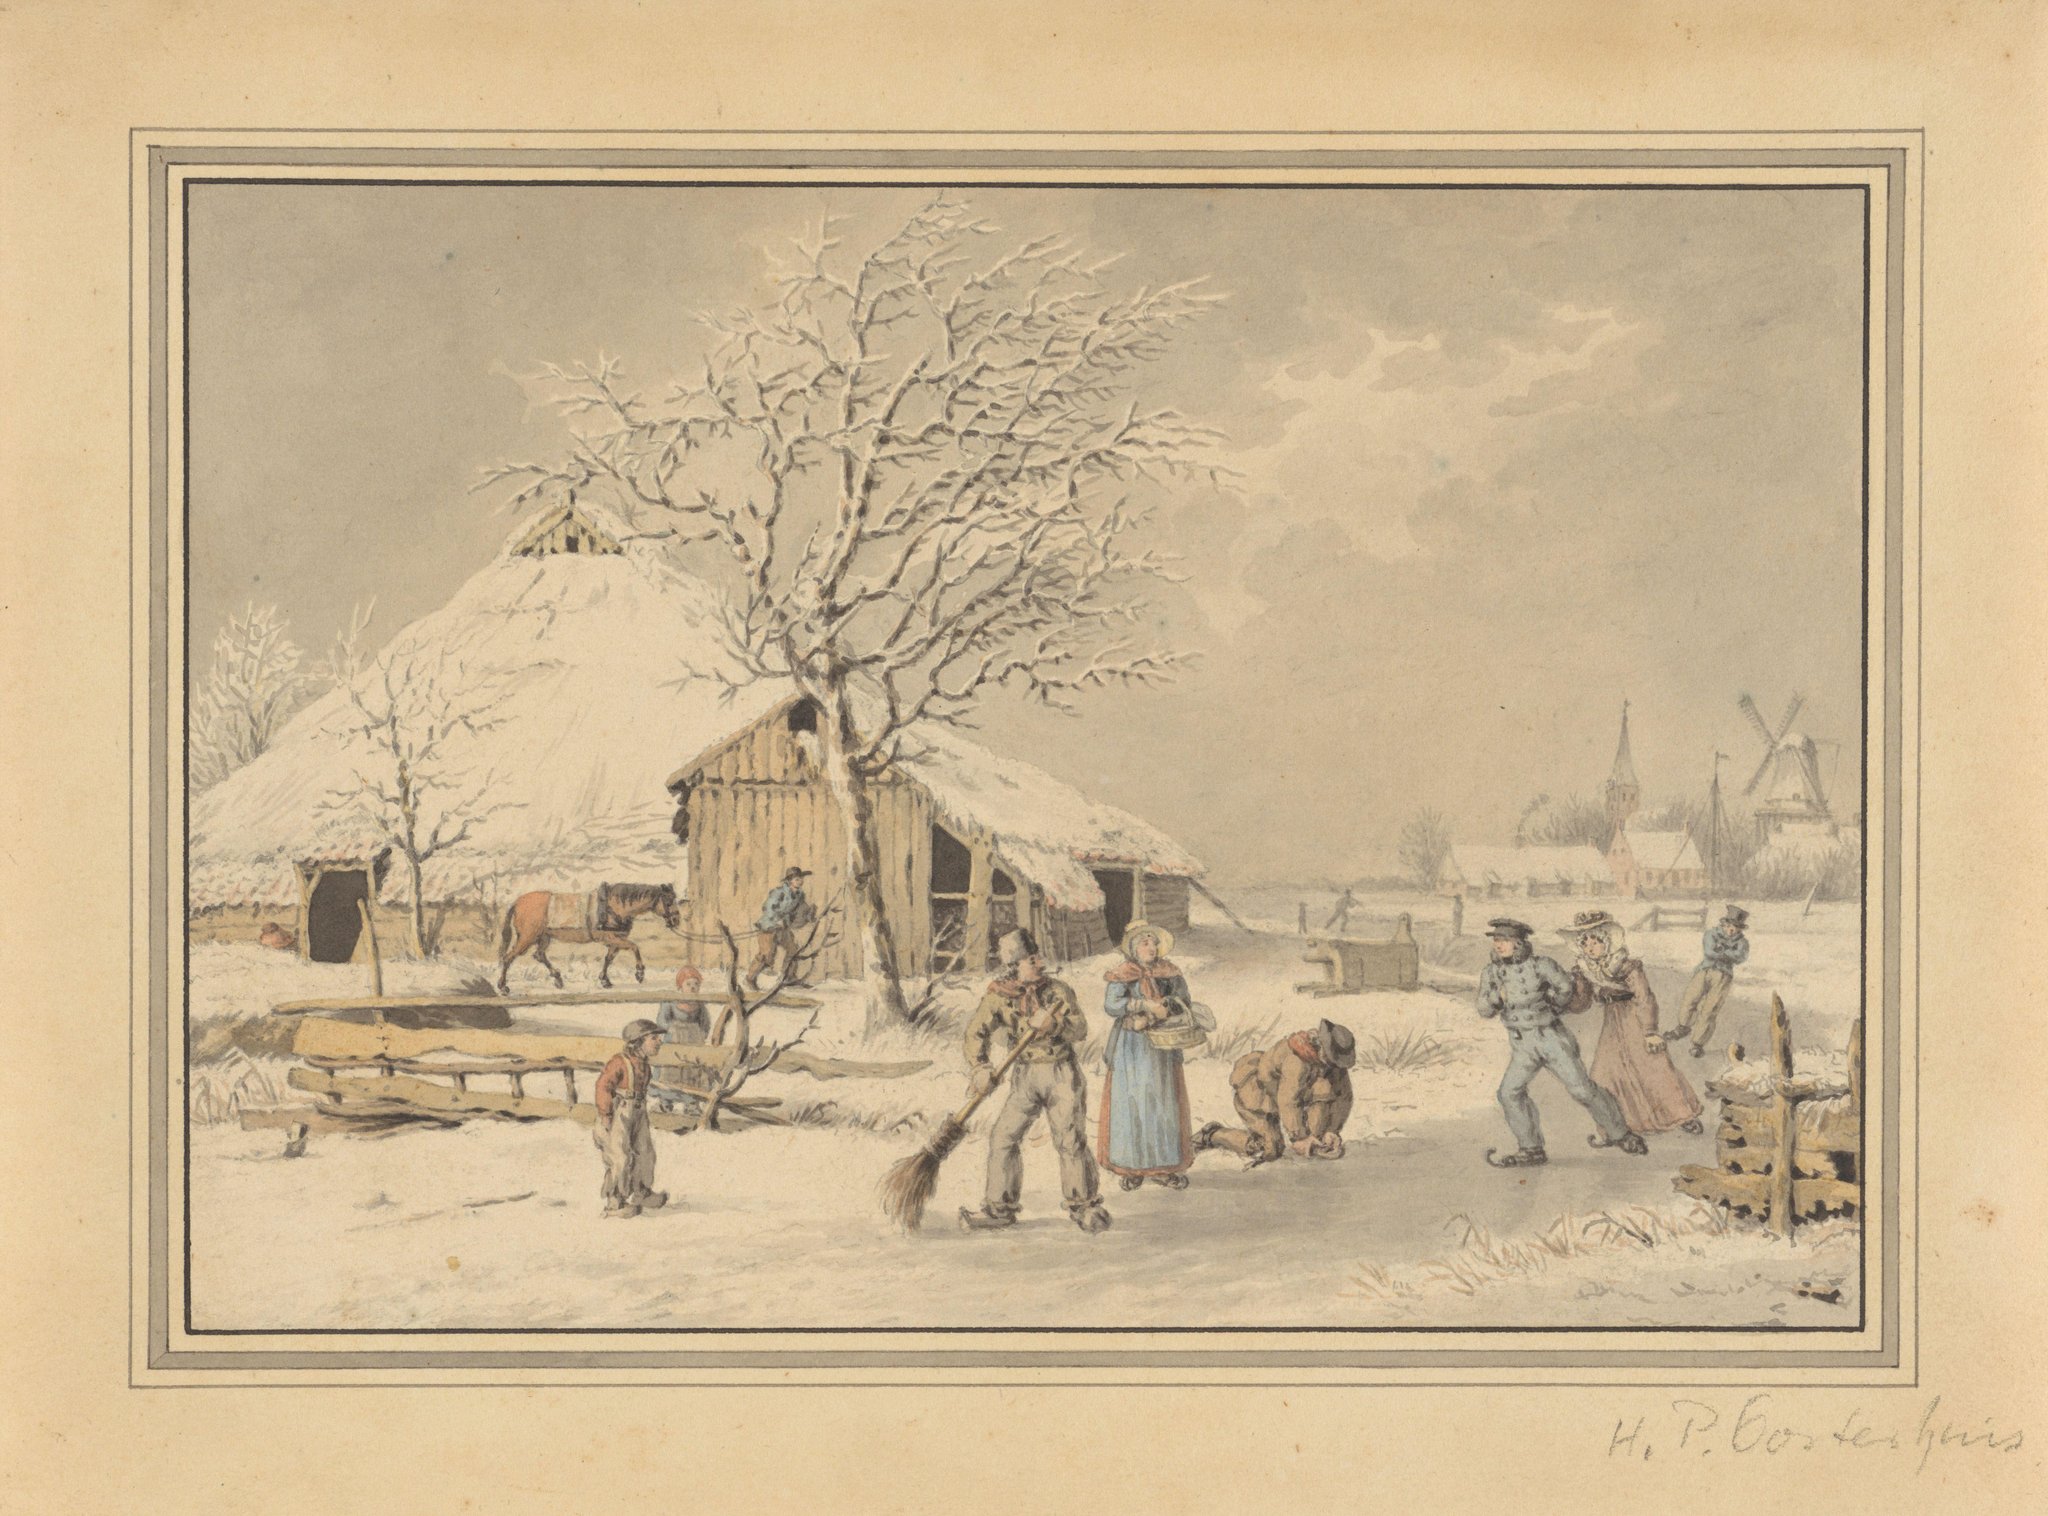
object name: watercolor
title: Winterlandschap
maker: haatje pieters oosterhuis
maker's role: draughtsman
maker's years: 1784-1854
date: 1794-1854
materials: paper, watercolor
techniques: brush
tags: playing with snow and ice - cc - adult(s) ~ snow and ice, ice ~ freezing weather